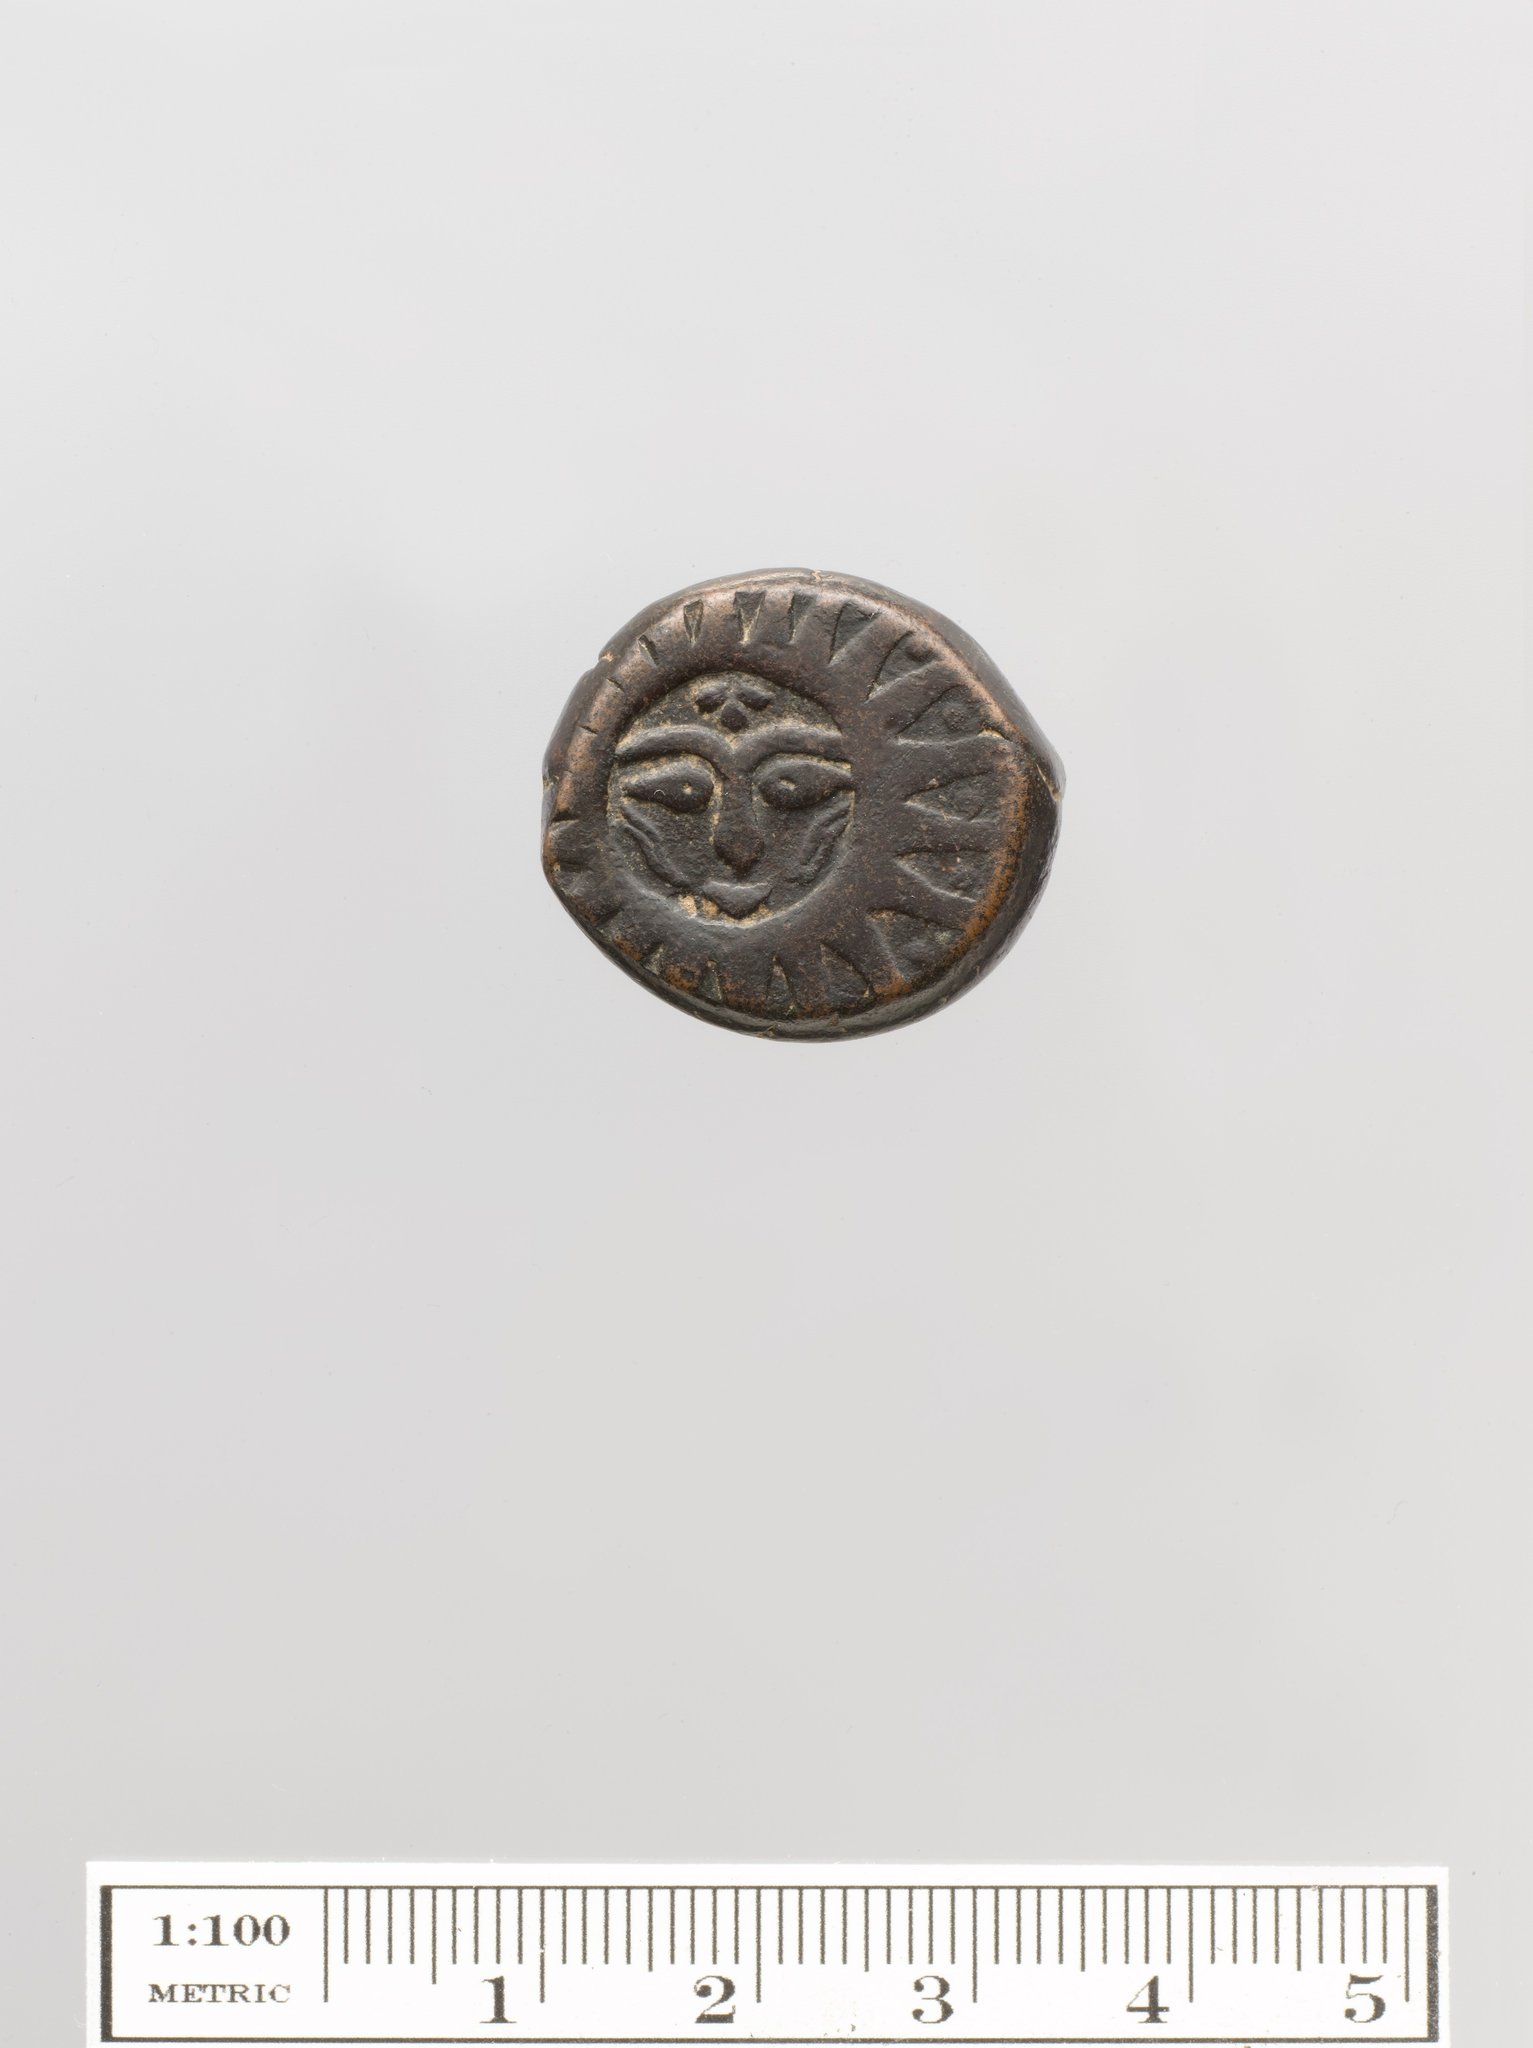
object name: coin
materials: copper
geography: iran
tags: faces